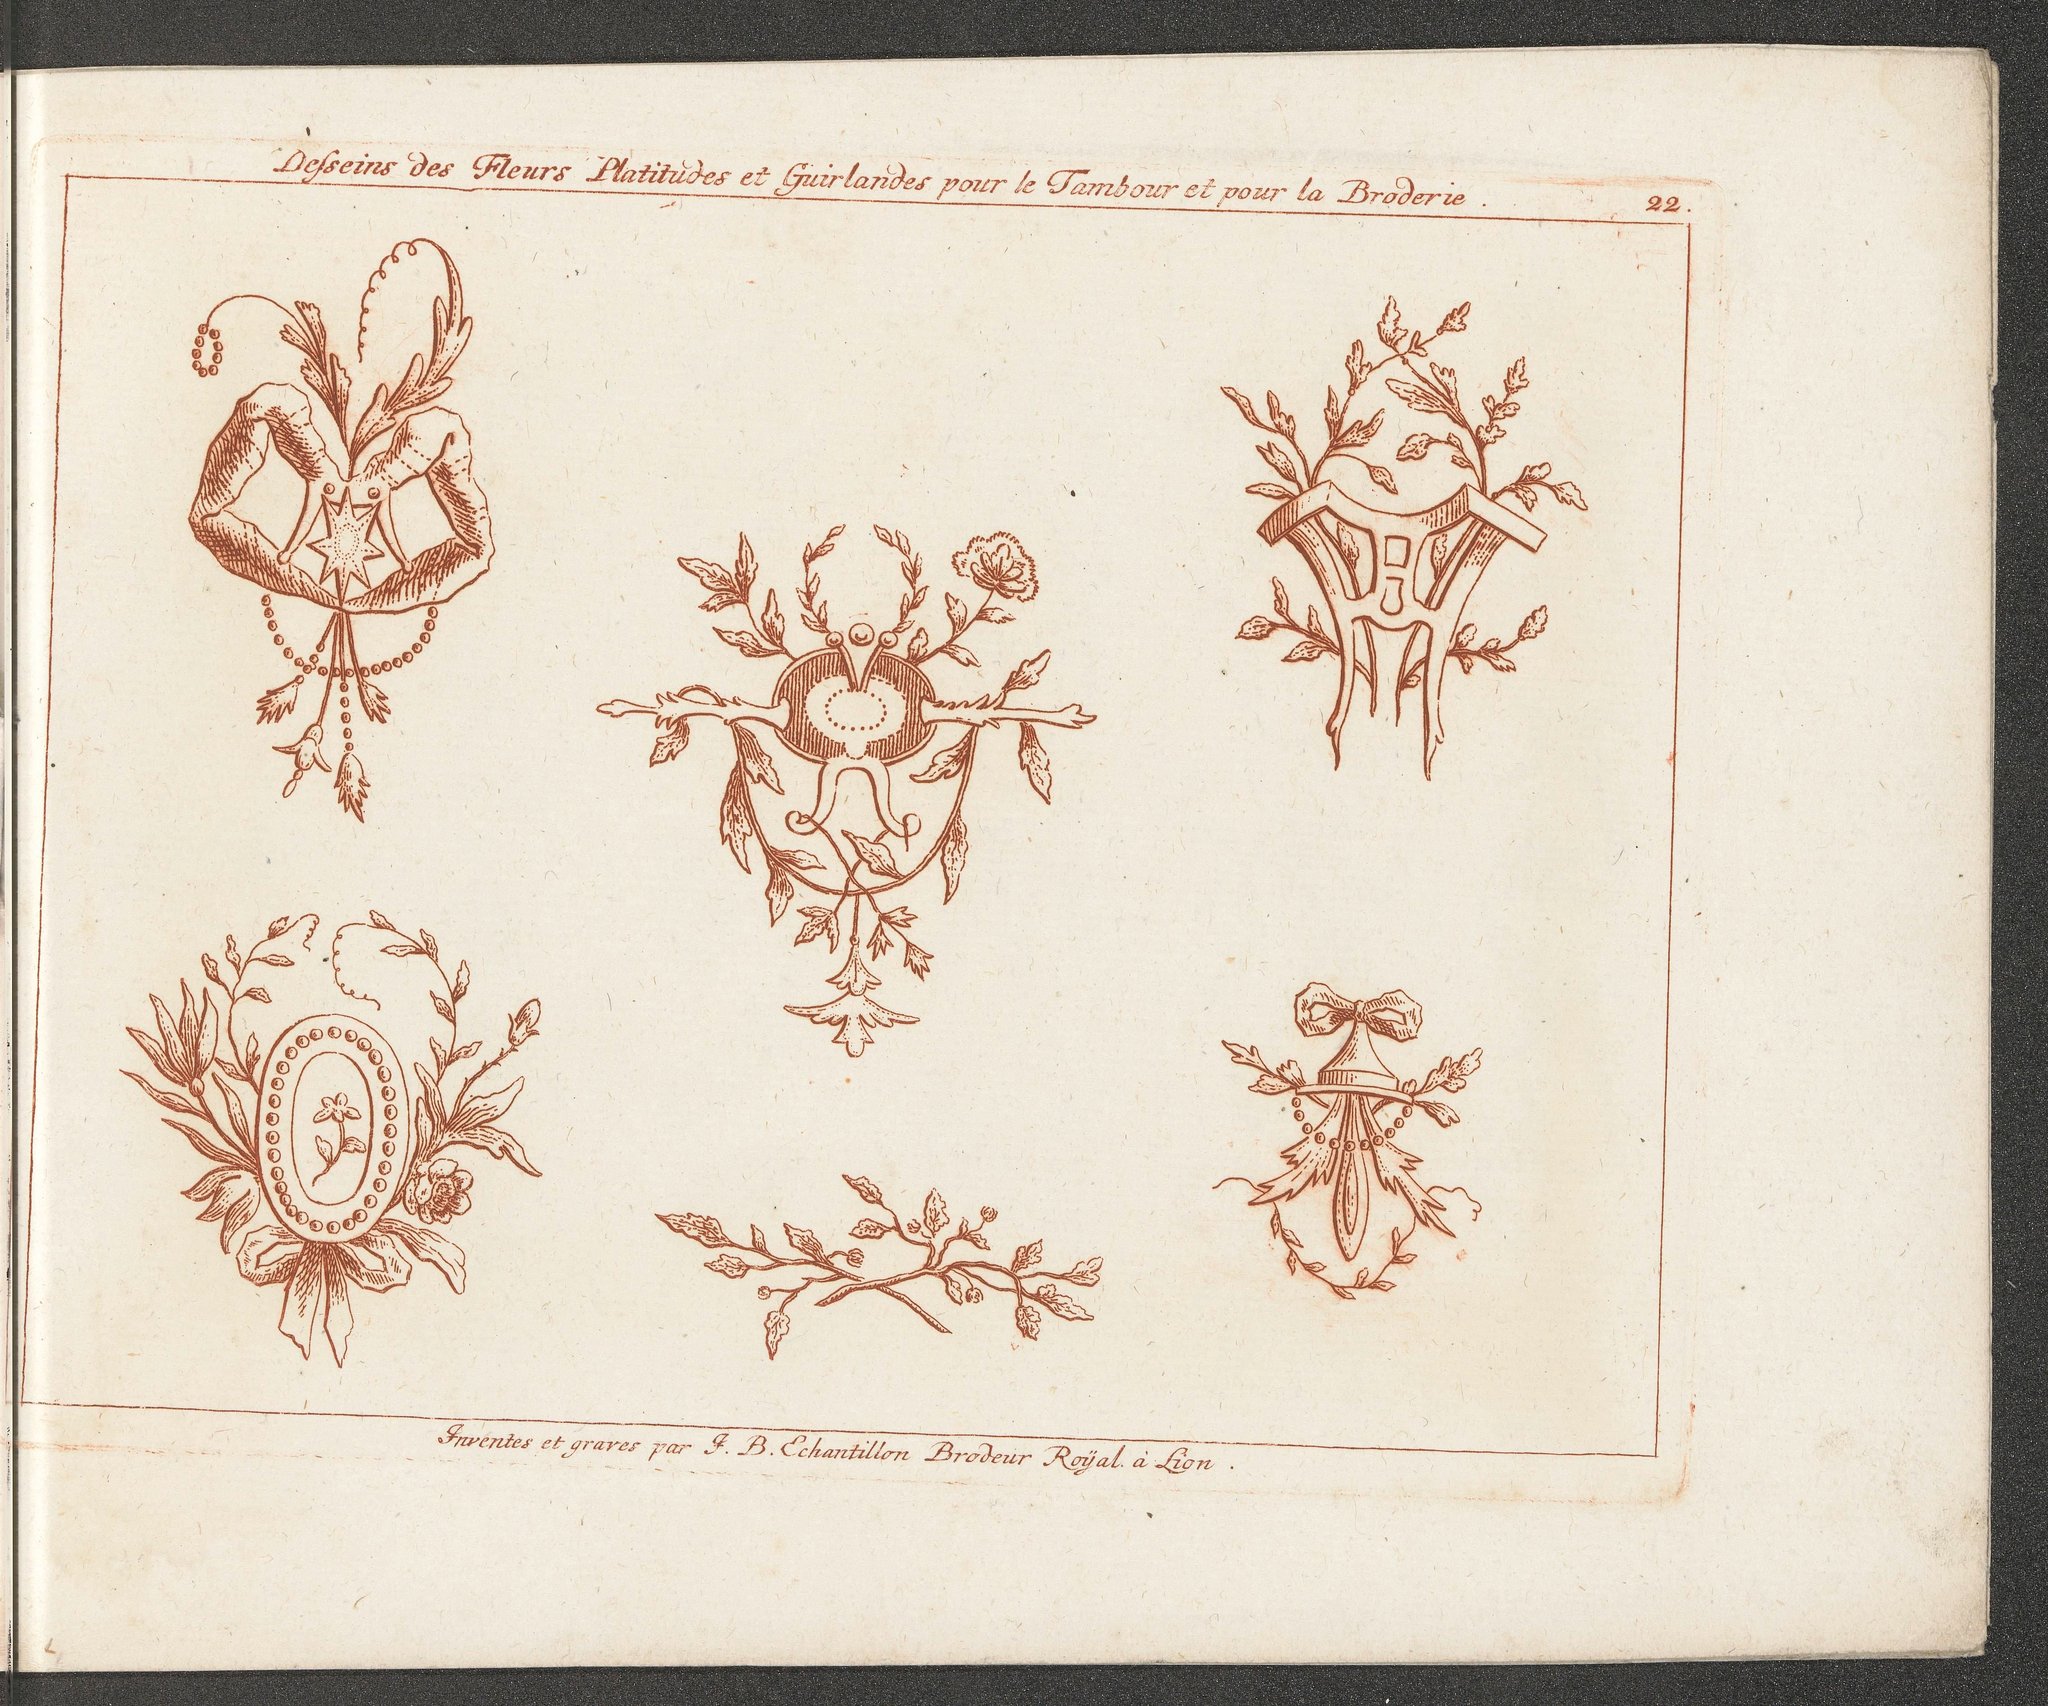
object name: print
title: Desseins des Fleurs Platitudes et Guirlandes pour le Tambour et pour la Broderie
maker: jean baptiste echantillon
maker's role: print maker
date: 1784-1785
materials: paper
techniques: etching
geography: lyon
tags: embroidery (ornamentation)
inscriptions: collector's mark: Lugt 2760, collector's mark: Lugt 2228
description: Zes motieven met ranken en bladmotieven, links onder met een ovaal medaillon, rechts onder met een strik.